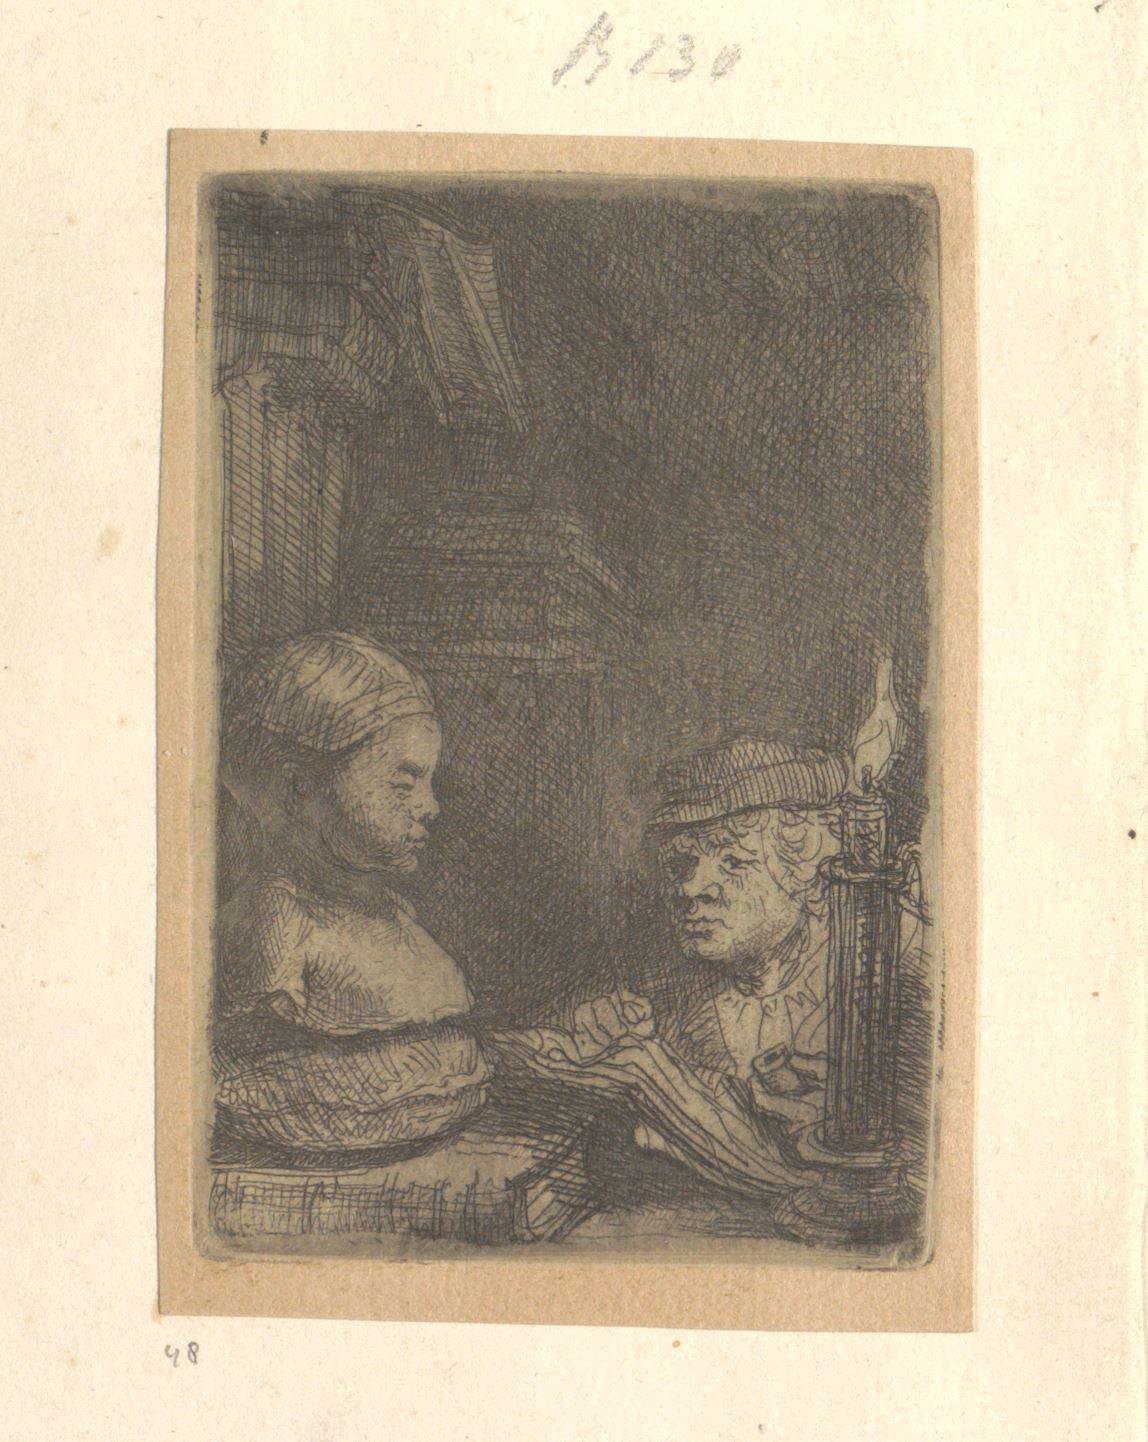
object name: album leaf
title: Man, tekenend naar een gipsmodel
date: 1639-1643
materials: paper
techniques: etching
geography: paris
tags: drawing, art (+ artist studying classical remains)